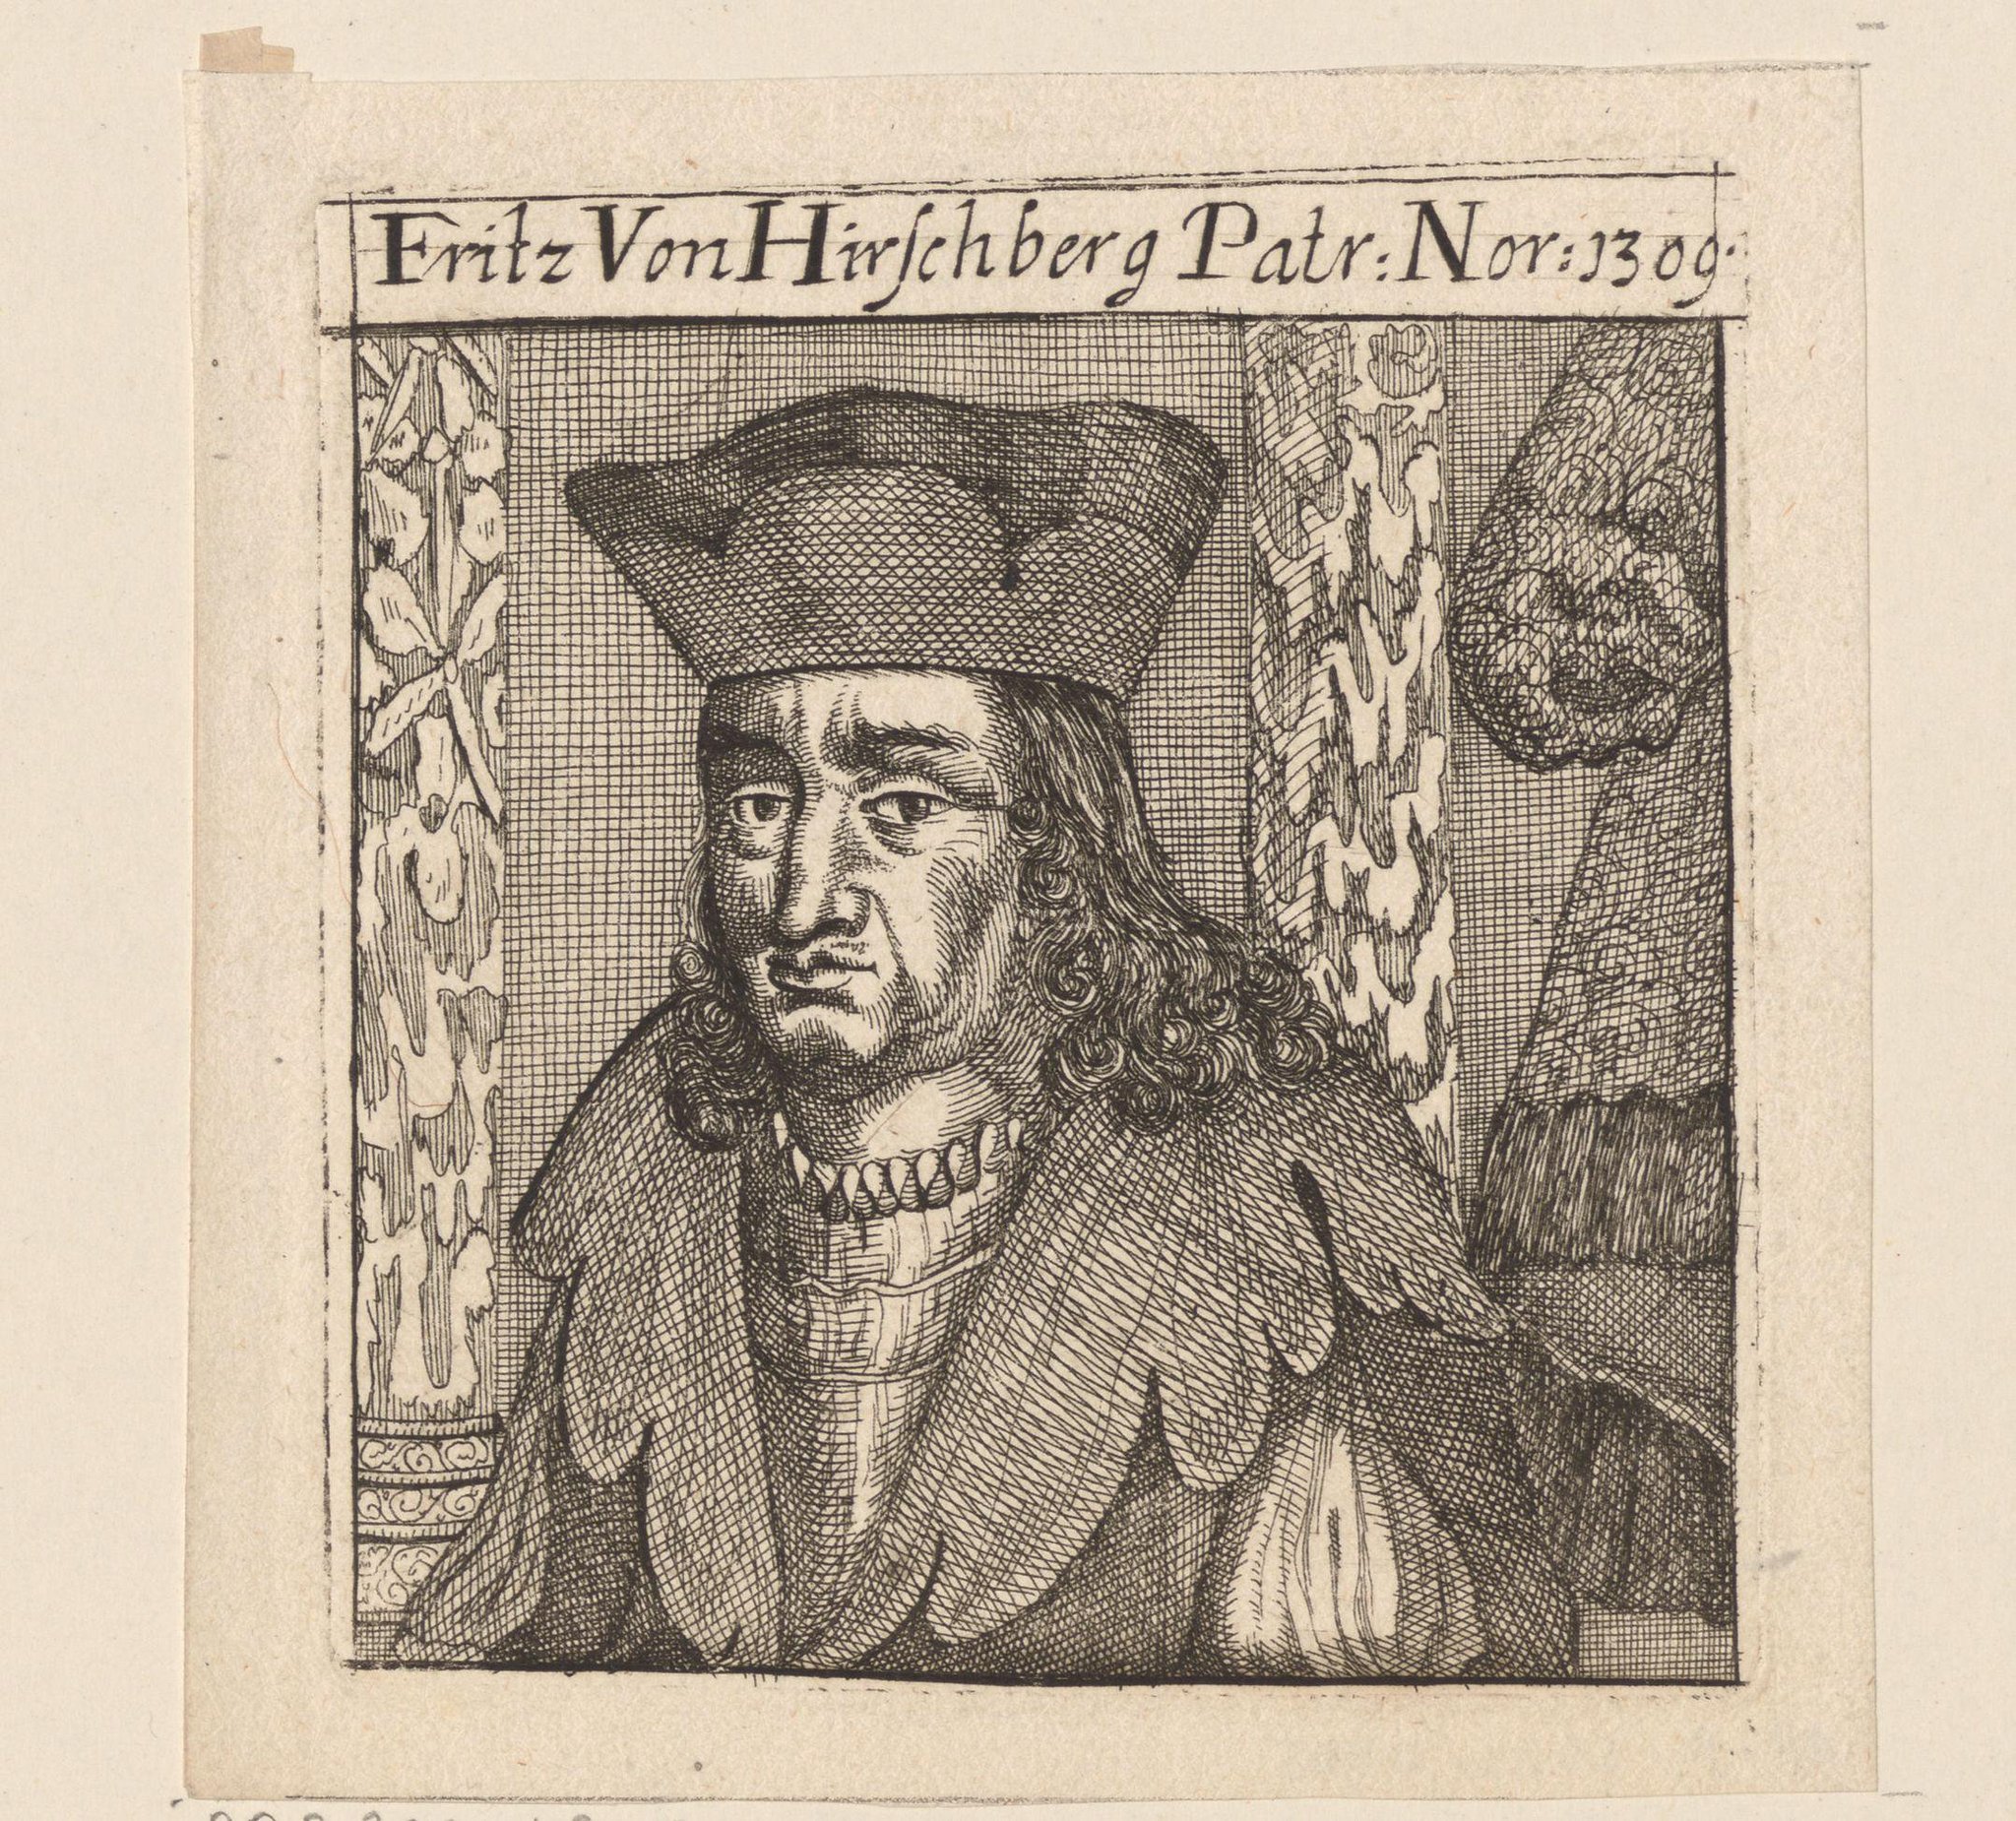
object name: print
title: Portret van Fritz von Hirschberg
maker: Anonymous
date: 1700-1799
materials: paper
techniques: etching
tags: historical persons